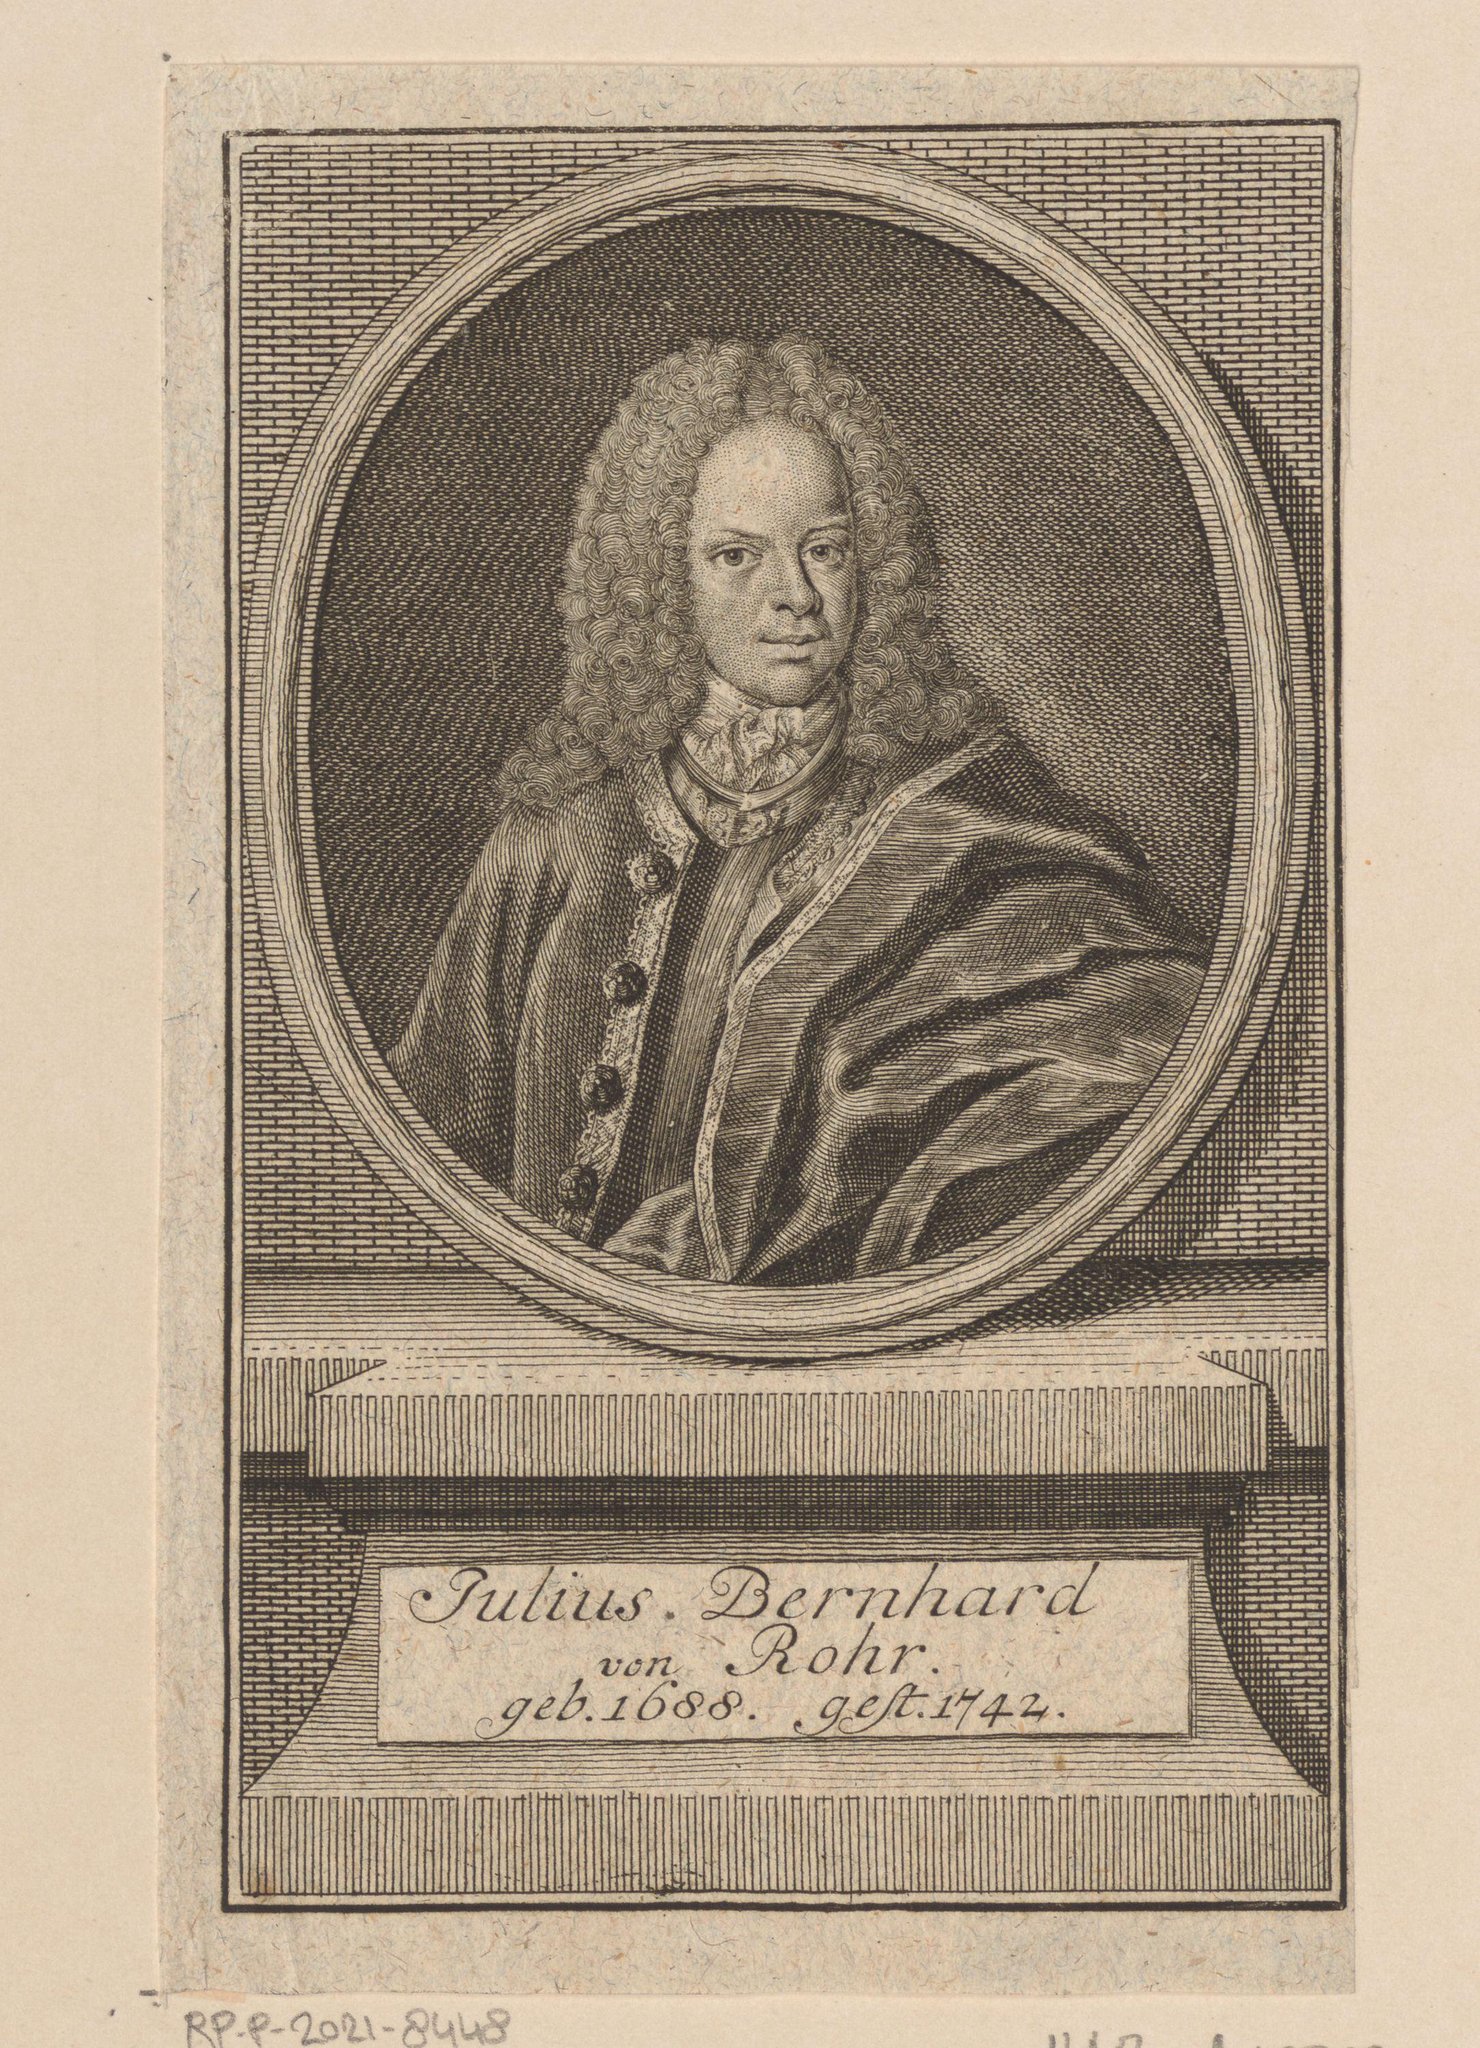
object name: print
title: Portret van Julius Bernhard von Rohr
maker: johann christoph sysang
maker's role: print maker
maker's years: 1703-1757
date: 1754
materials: paper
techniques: engraving, etching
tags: historical persons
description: Prent mogelijk uit: Leipziger Sammlungen von Wirthschafftlichen (...). Leipzig: Carl Ludwig Jacobi, 1754, dl. 10.